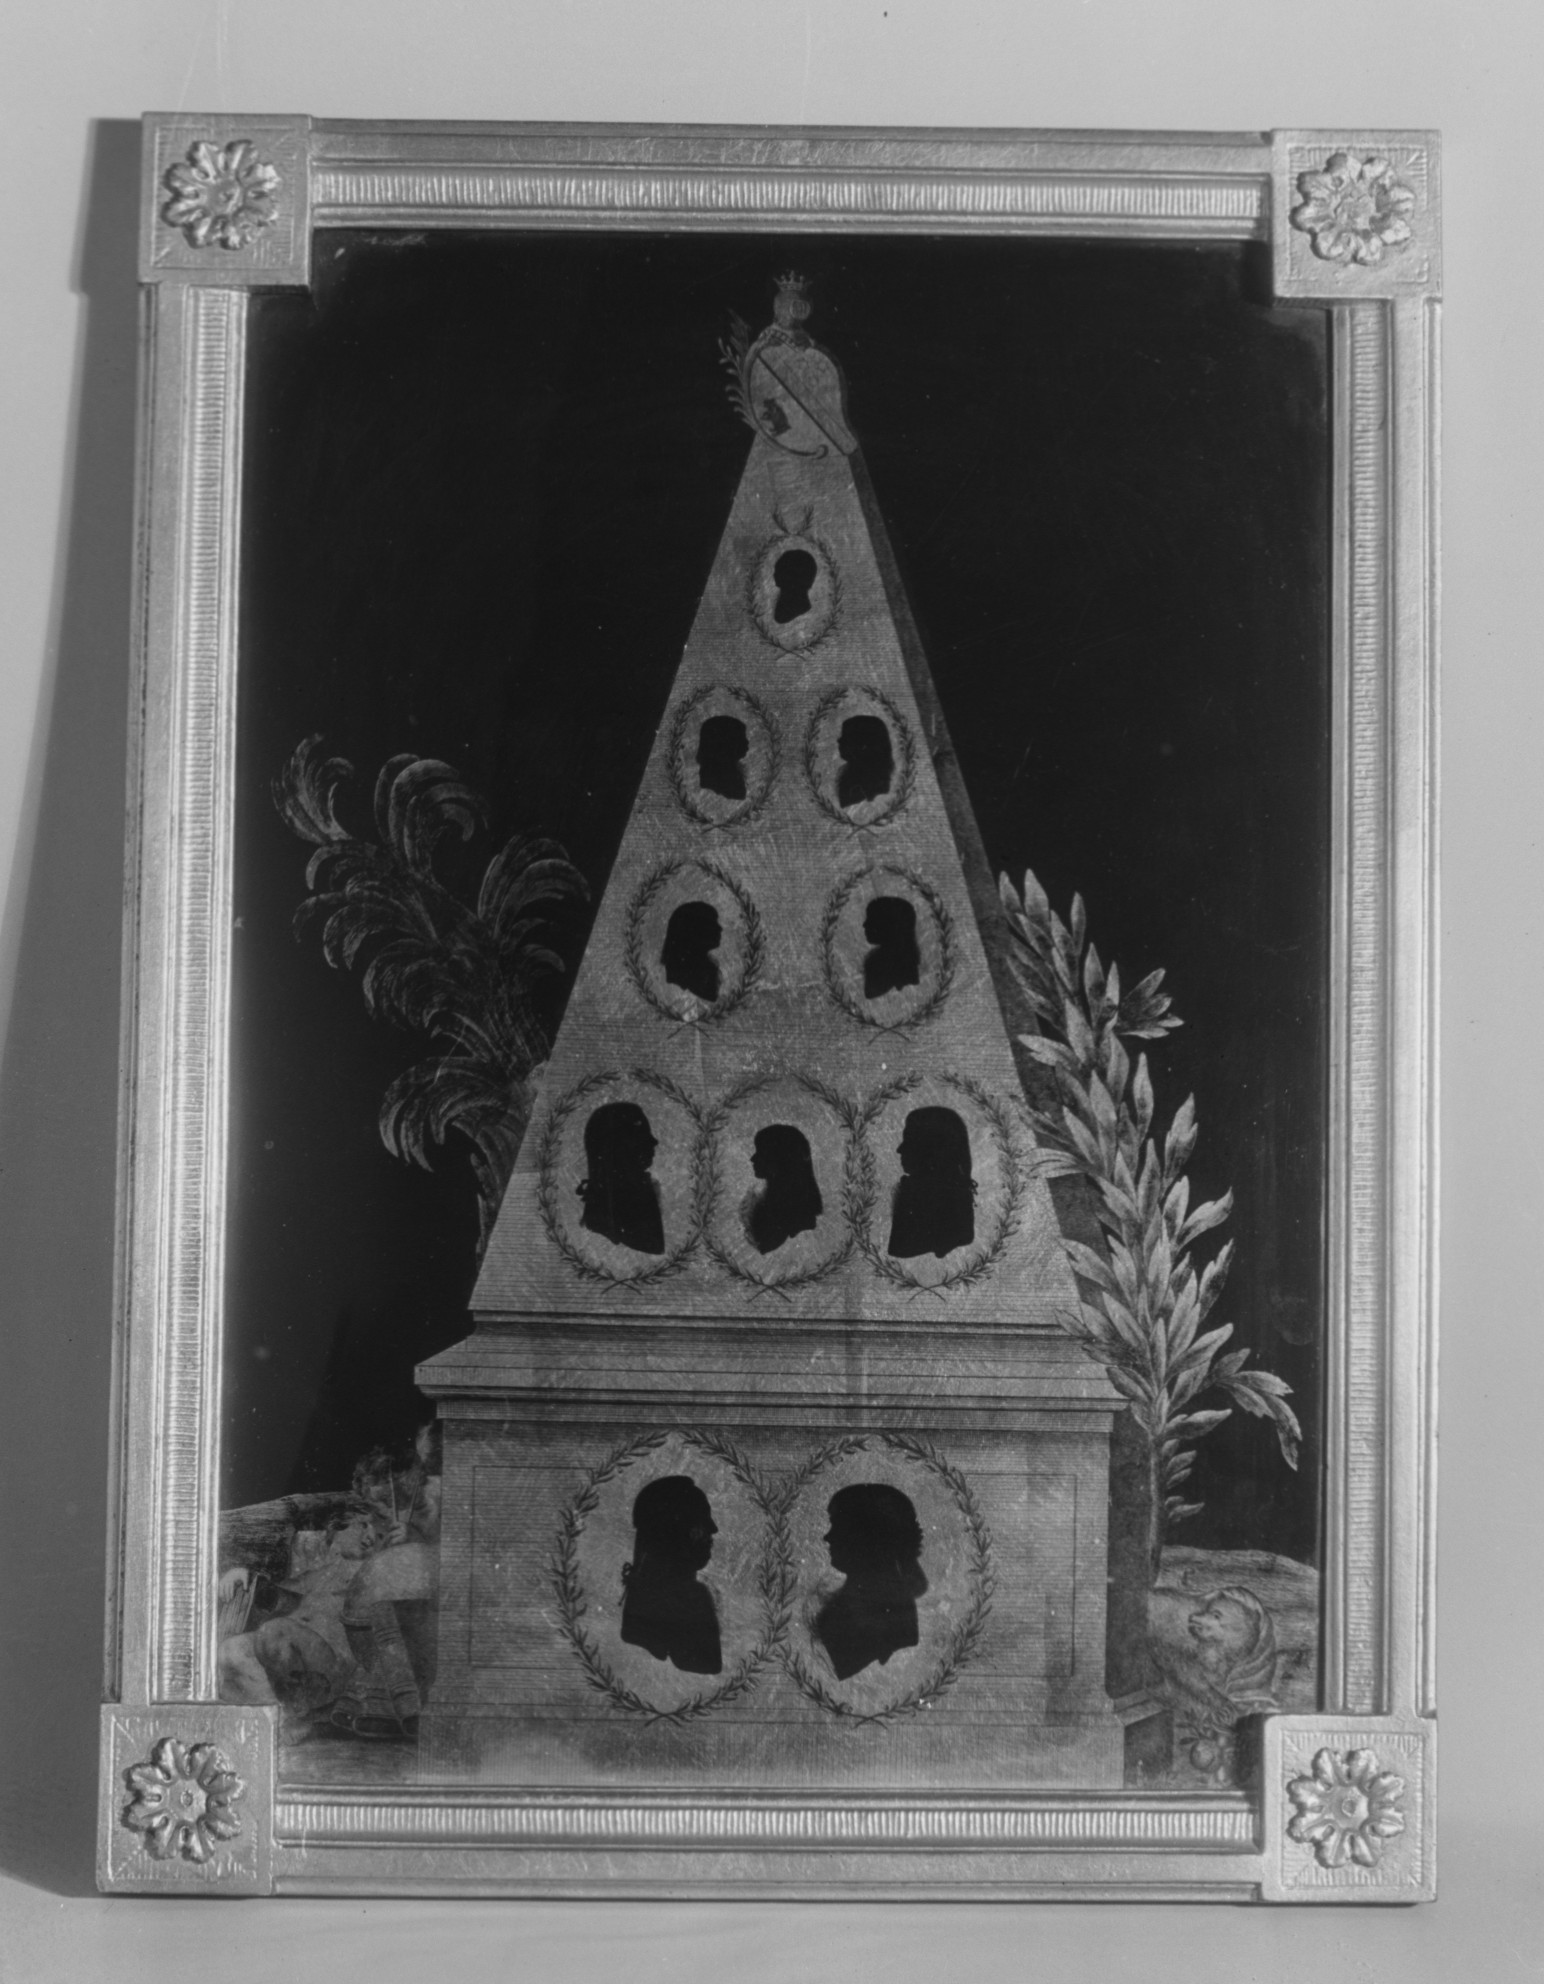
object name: panel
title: Silhouettes of husband and wife, with eight children, said to represent the Von Baer family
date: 1767-1800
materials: gilt, glass, wood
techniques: painting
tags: profiles,family